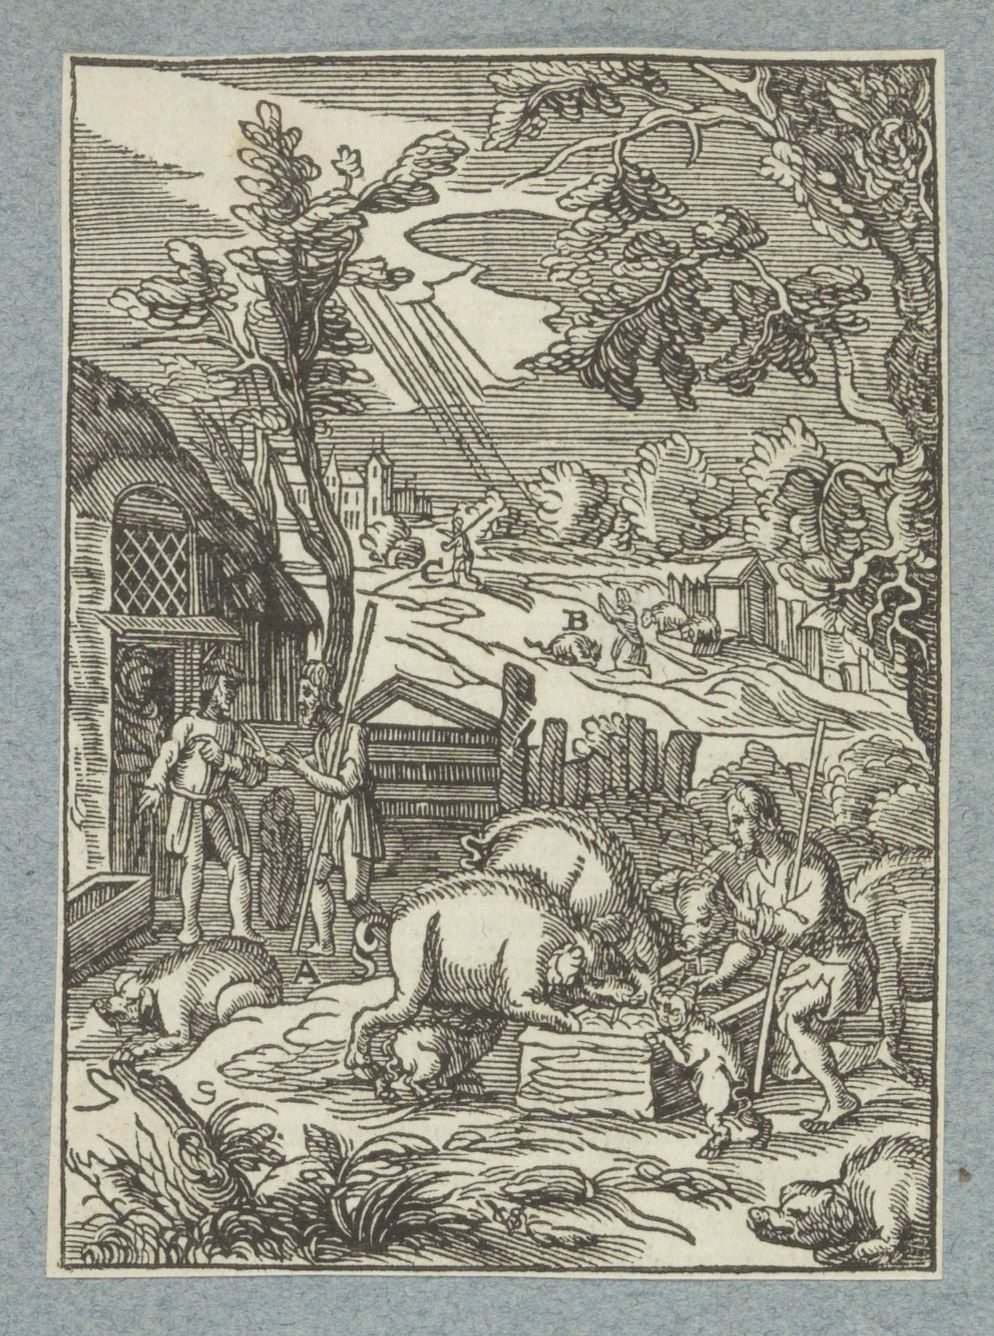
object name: print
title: Verloren zoon als varkenshoeder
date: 1629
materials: paper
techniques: letterpress printing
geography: amsterdam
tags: the prodigal son, suffering want, asks a farmer for work, the prodigal son repents his former life and prays, the prodigal son tends the swine and eats from their trough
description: De verloren zoon heeft zijn erfenis verkwist en verhuurt zichzelf bij een boer als varkenshoeder. Hij knielt tussen de varkens om met hen samen uit de voederbak te eten. Op de achtergrond komt hij tot inkeer en vertrekt hij naar zijn vader. Bij verschillende elementen uit de voorstelling staan letters. De prent maakt deel uit van een album.